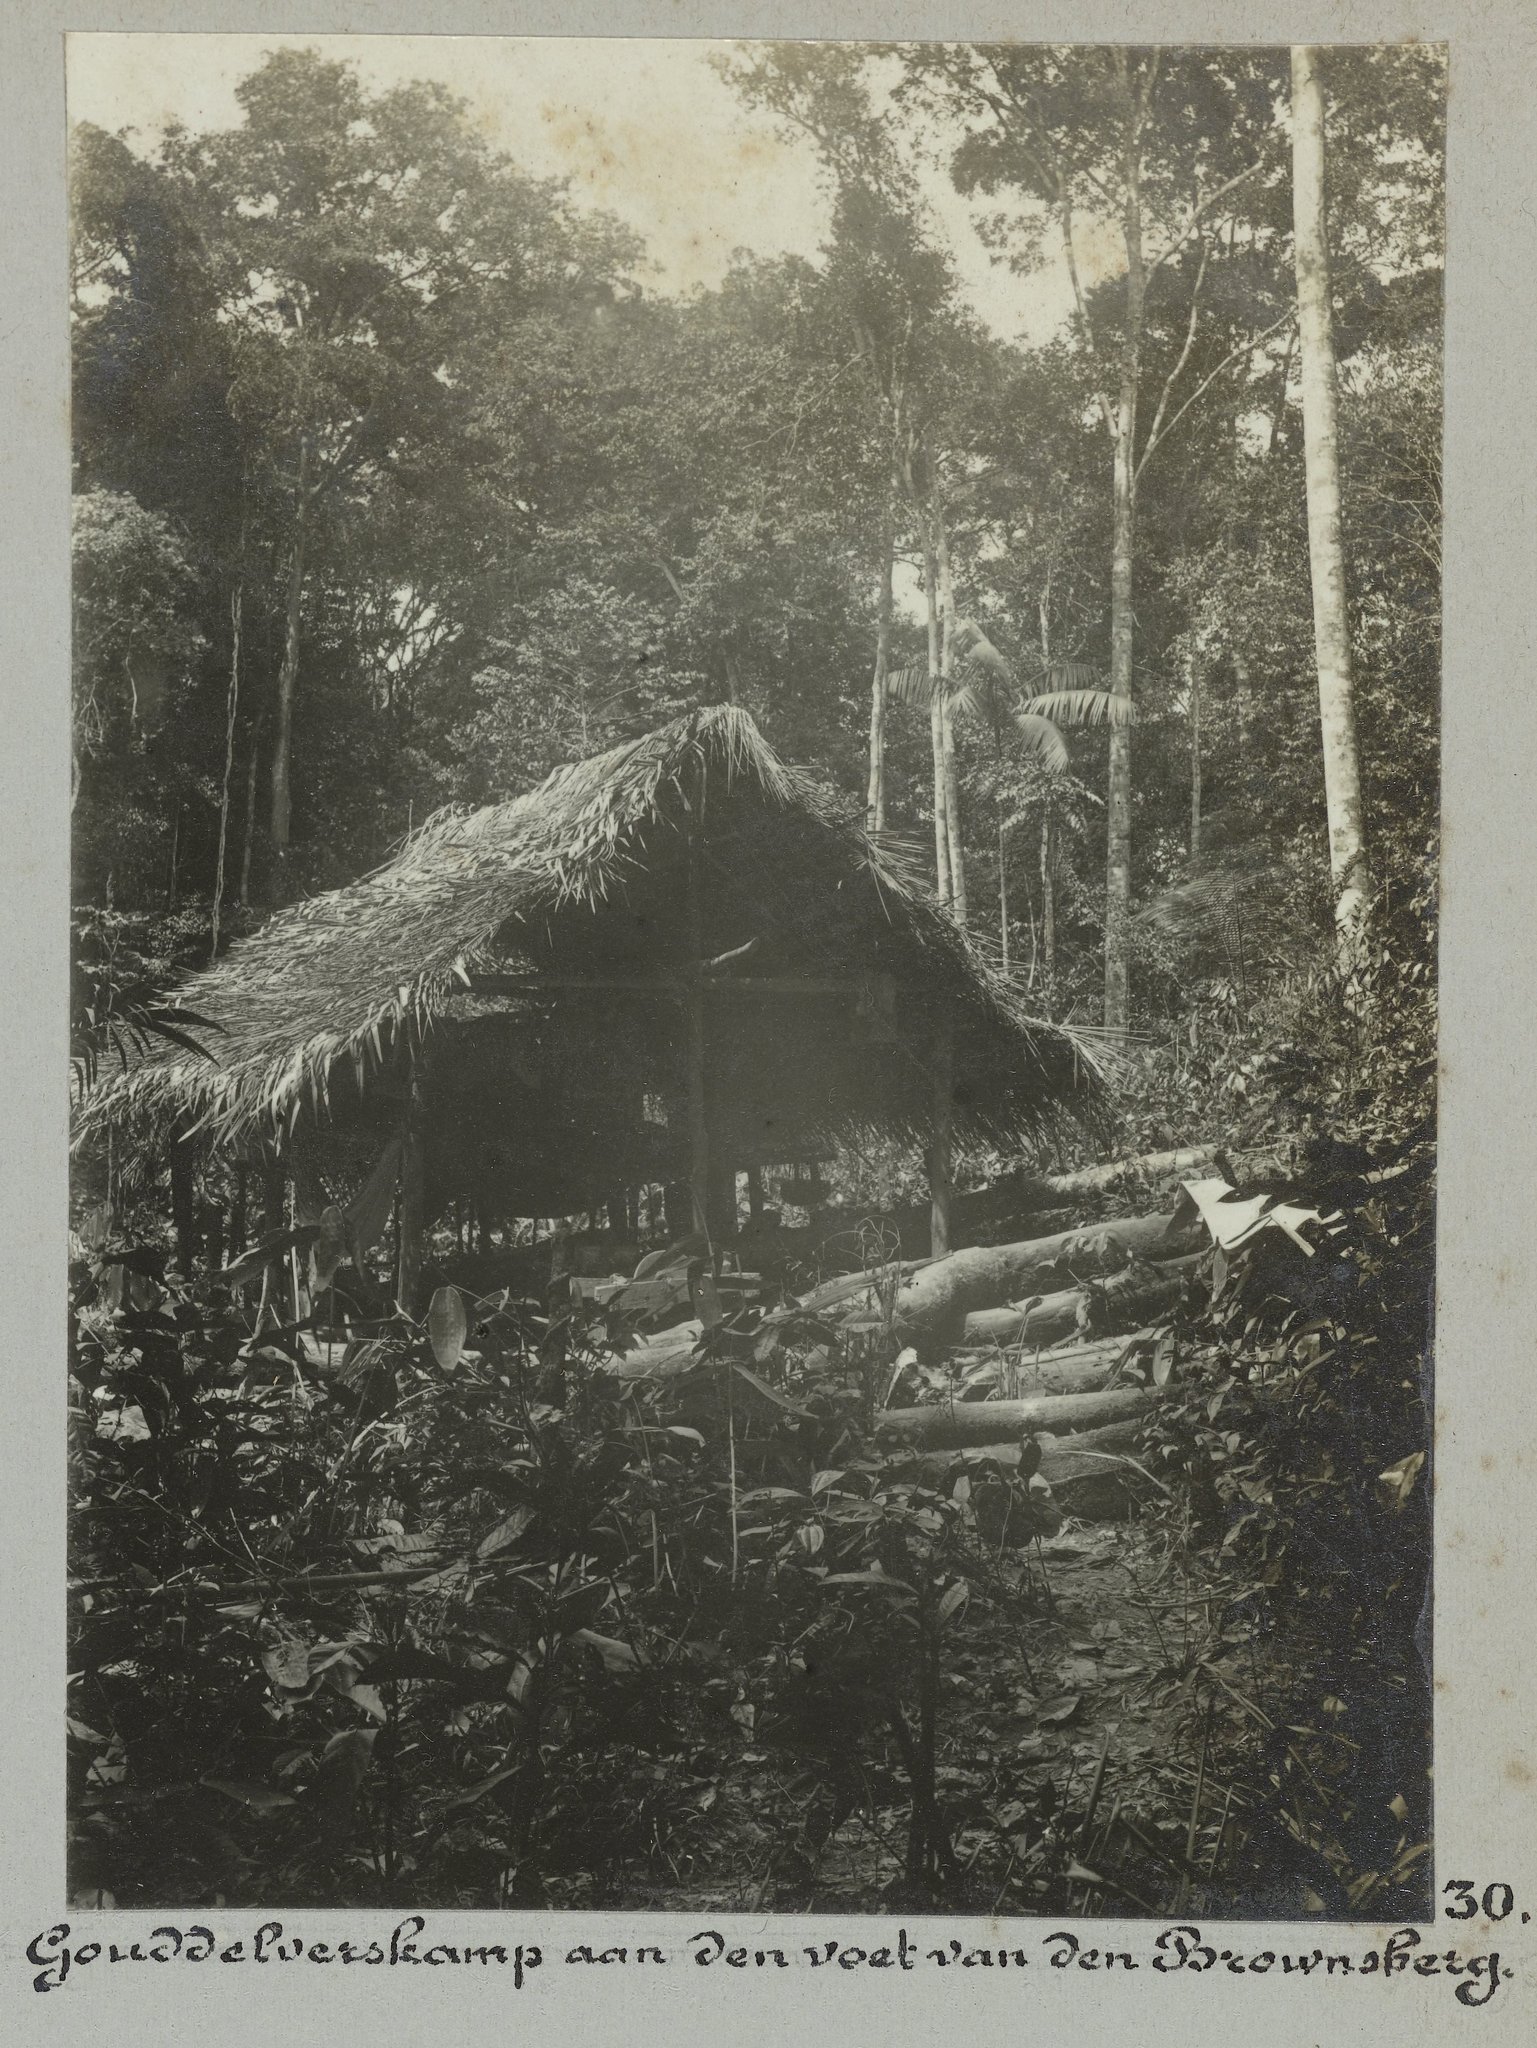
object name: photograph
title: Gouddelverskamp aan den voet van den Brownsberg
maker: hendrik doijer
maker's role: engineer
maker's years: 1863-1925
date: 1903-1910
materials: photographic support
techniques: gelatin silver print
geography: suriname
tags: suriname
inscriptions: inscription: ‘30. / Gouddelverskamp aan den voet van den Brownsberg.’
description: Hut in het kamp van goudzoekers bij de Browns Berg. Onderdeel van het fotoalbum Souvenir de Voyage (deel 1), over het leven van de familie Doijer in en rond de plantage Ma Retraite in Suriname in de jaren 1903-1910.